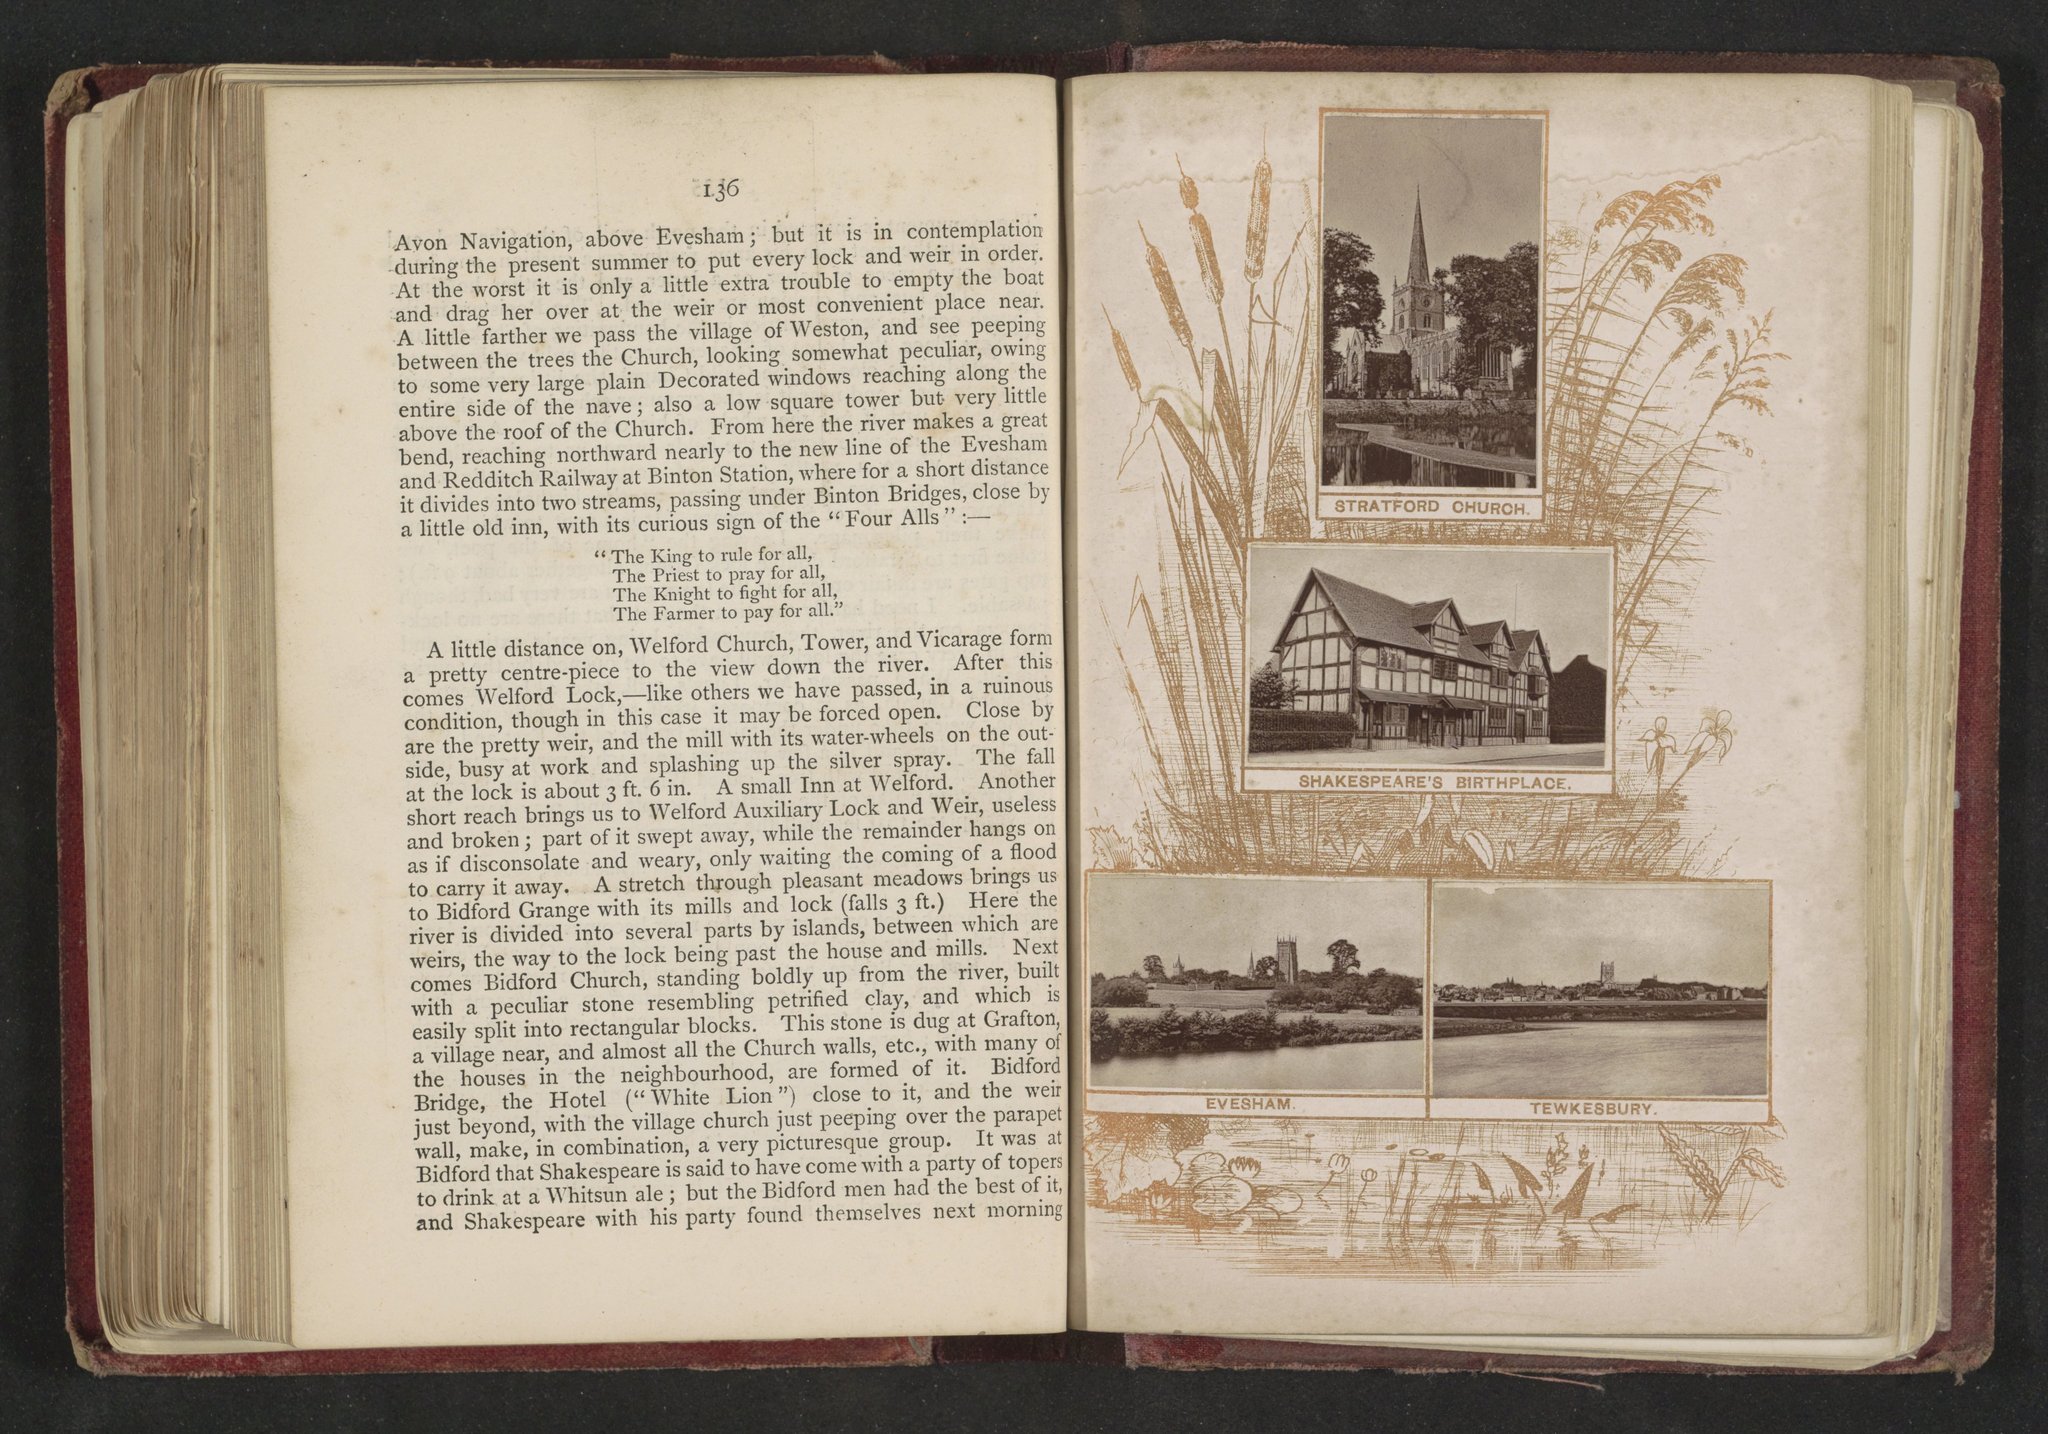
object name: print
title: Vier gebouwen langs de Theems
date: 1878-1879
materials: paper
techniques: engraving, woodburytype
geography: england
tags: river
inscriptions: inscription: ‘Stratford church. Shakespeare's birthplace. Evesham. Tewksbury.’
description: Boven: gezicht op de kerk in Stratford, midden: gezicht op het geboortehuis van William Shakespeare in Stratford-upon-Avon, onder: gezicht op Evesham en Tewkesbury.